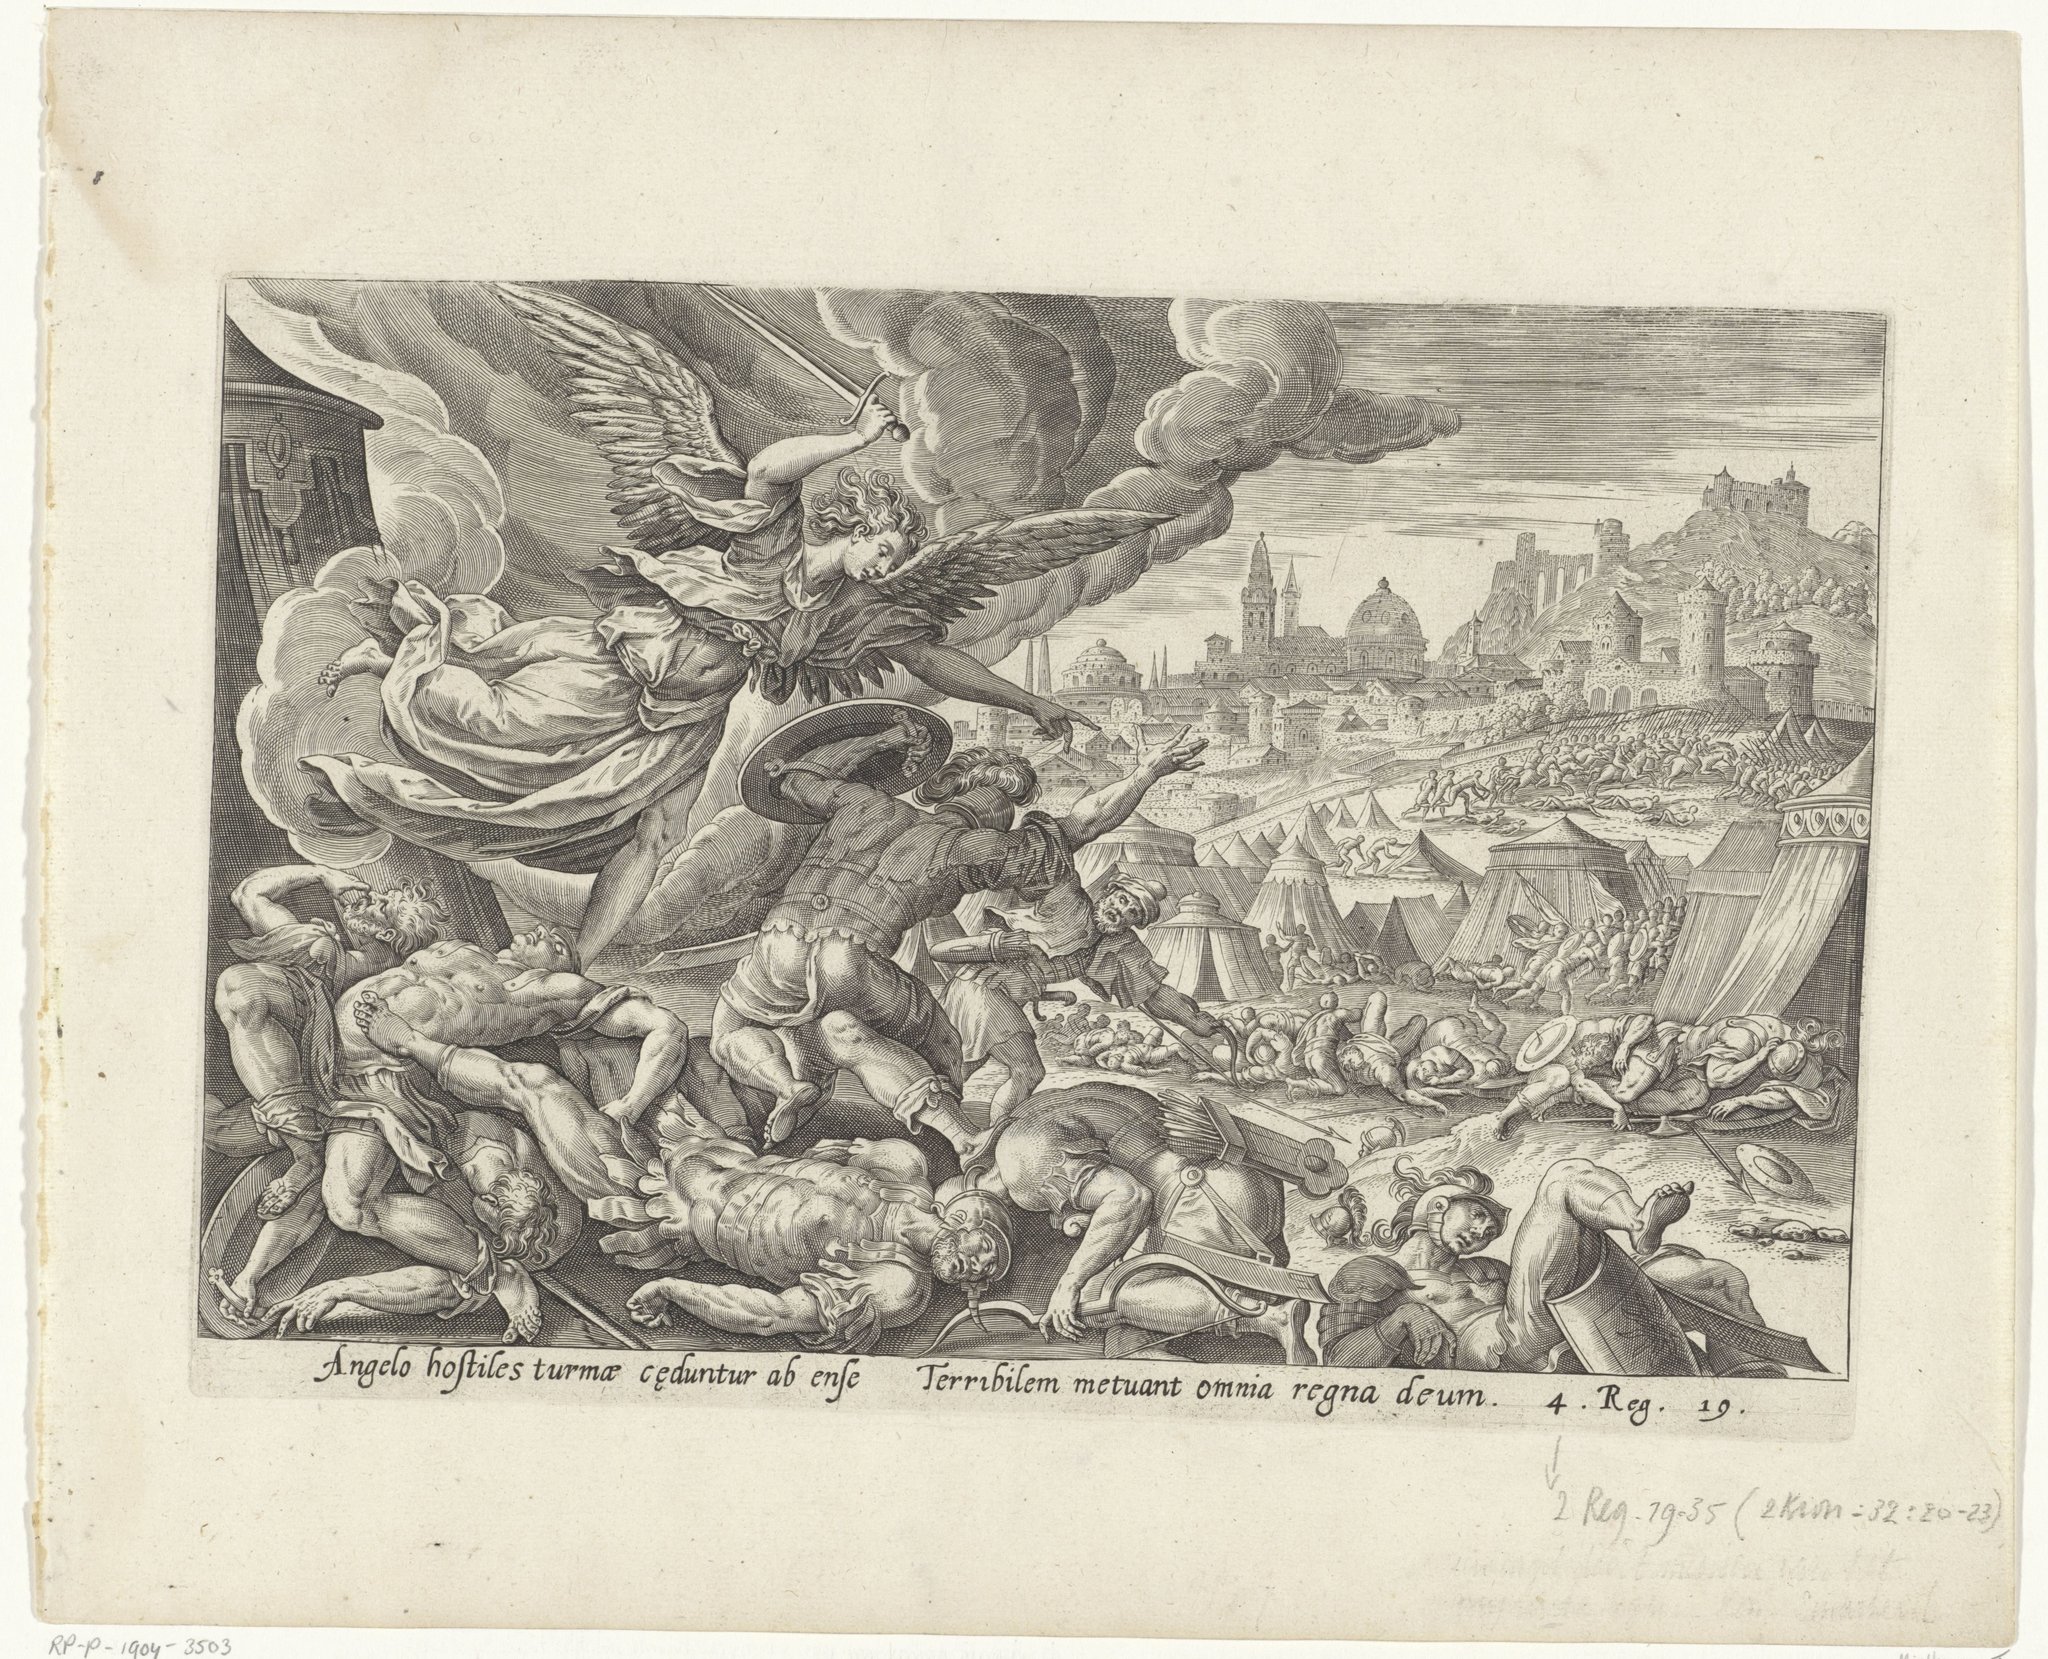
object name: print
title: Geschiedenis van Hizkia en Sanherib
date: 1585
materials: paper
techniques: engraving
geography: antwerp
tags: at night, an angel of the lord decimates the assyrian camp: 185.000 soldiers are killed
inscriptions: collector's mark: Lugt 2228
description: Prent gebruikt in: Thesaurus sacrarum historiaru[m] veteris (et novi) testame[n]ti, elega[n]tissimis imaginibus expressu[m] excelle[n]tissimoru[m] in hac arte viroru[m] opera : nu[n]c primu[m] in luce[m] editus. Antwerpen: Gerard de Jode, 1585.